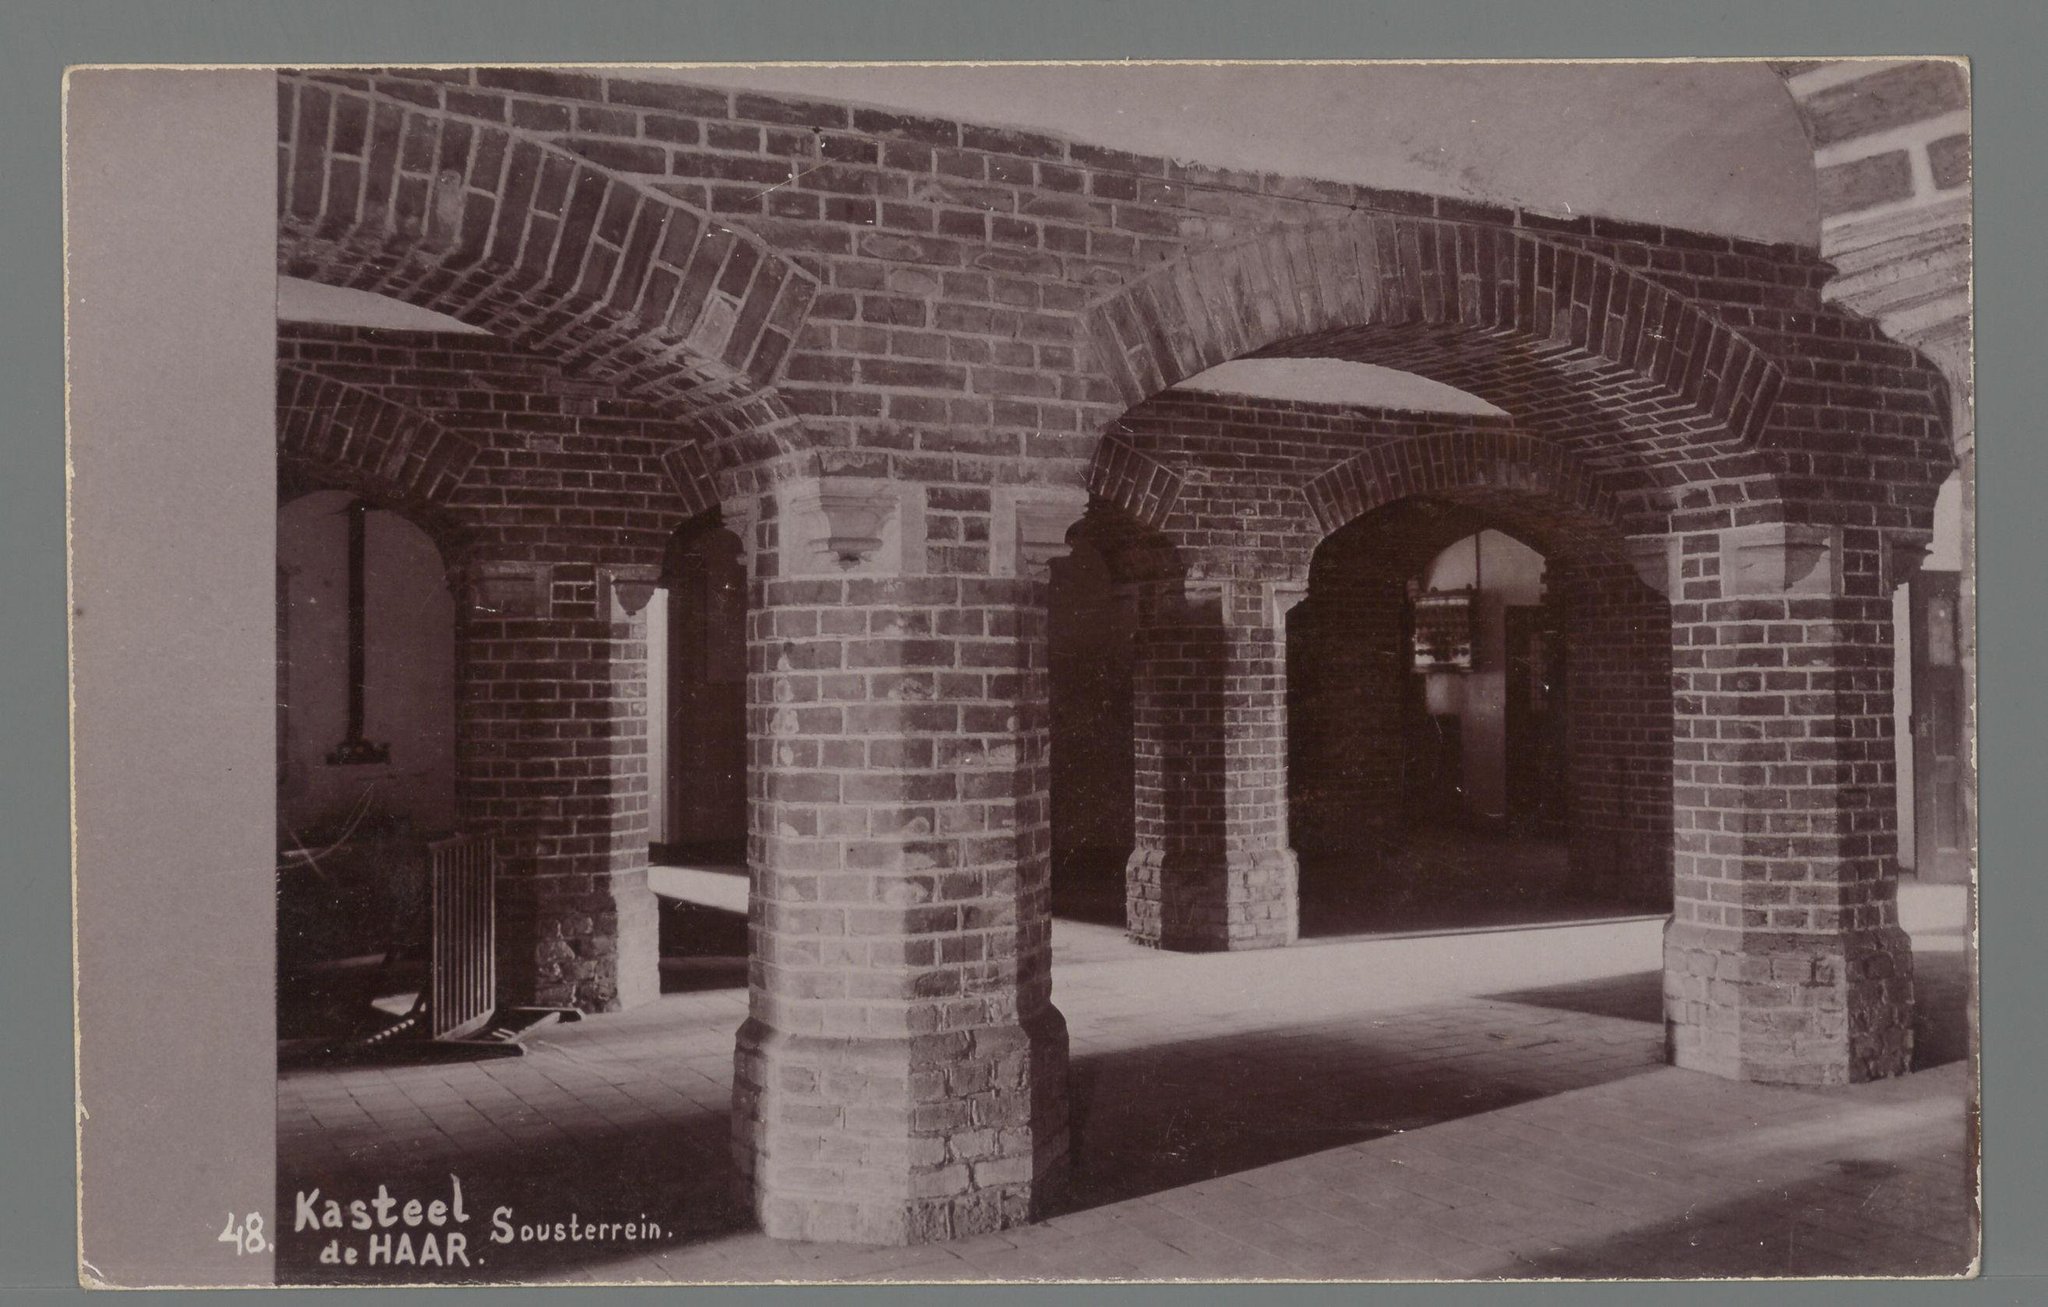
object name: photograph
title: Kasteel de Haar. Sousterrein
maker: Anonymous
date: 1900-1930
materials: paper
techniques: collodion silver print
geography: haarzuilens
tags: castle, arch, archivolt ~ architecture